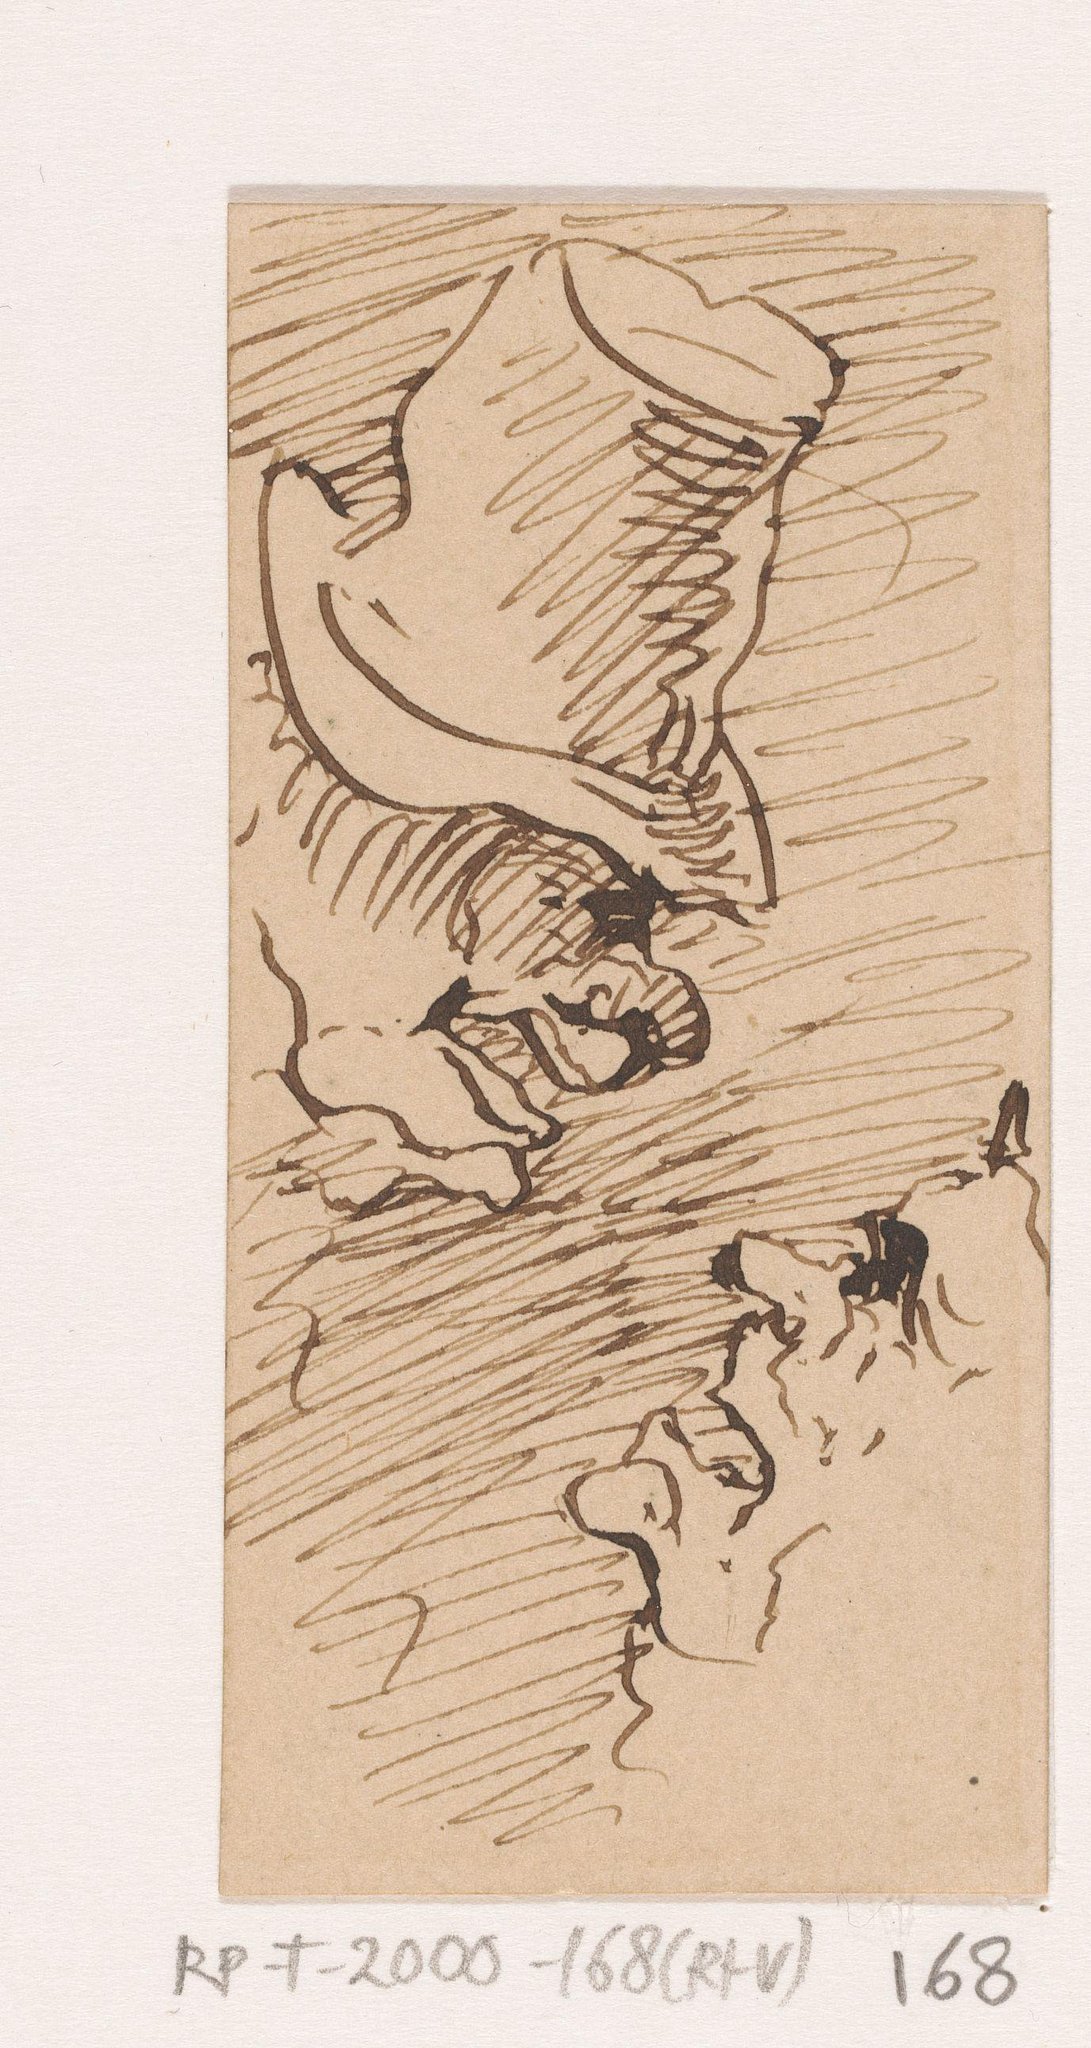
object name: drawing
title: Twee koppen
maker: johannes tavenraat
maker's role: draughtsman, painter, print maker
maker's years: 1809-1881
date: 1870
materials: cardboard, ink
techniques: pen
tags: caricatures (human types)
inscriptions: date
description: Twee karikaturale koppen in profiel. Getekend op de keerzijde van het visitekaartje van: 'Hend.k Bos'.